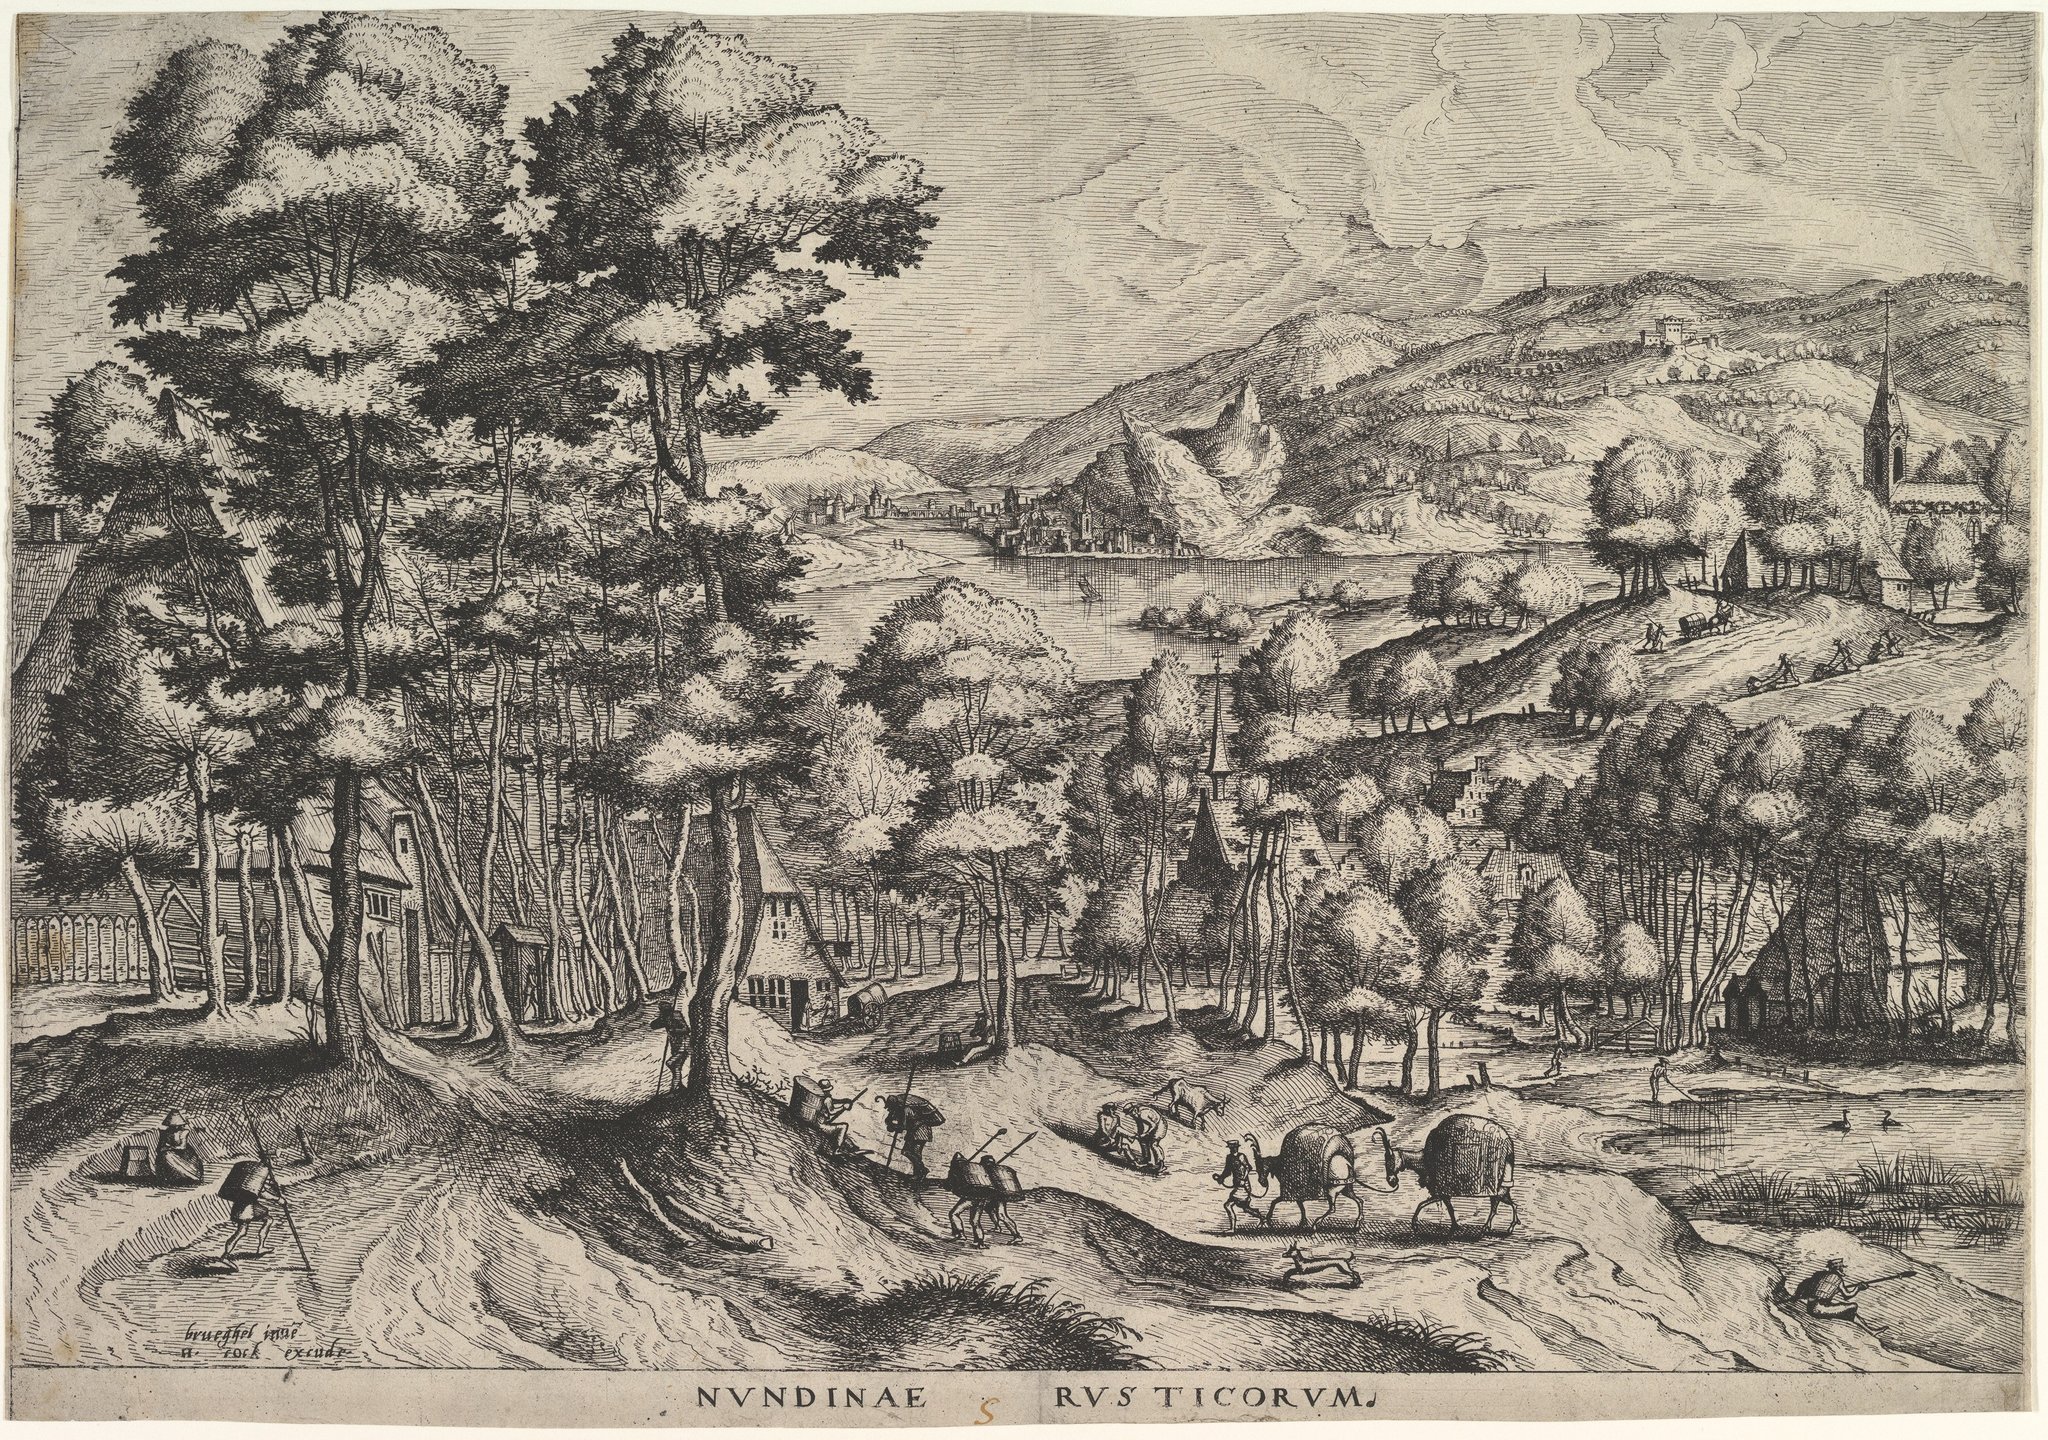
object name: print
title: Rustic Market (Nundinae Rusticorum), from "The Large Landscapes"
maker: pieter bruegel the elder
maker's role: artist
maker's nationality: netherlandish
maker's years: 1525-1569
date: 1555-1556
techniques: engraving, etching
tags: human figures,animals,landscapes,trees